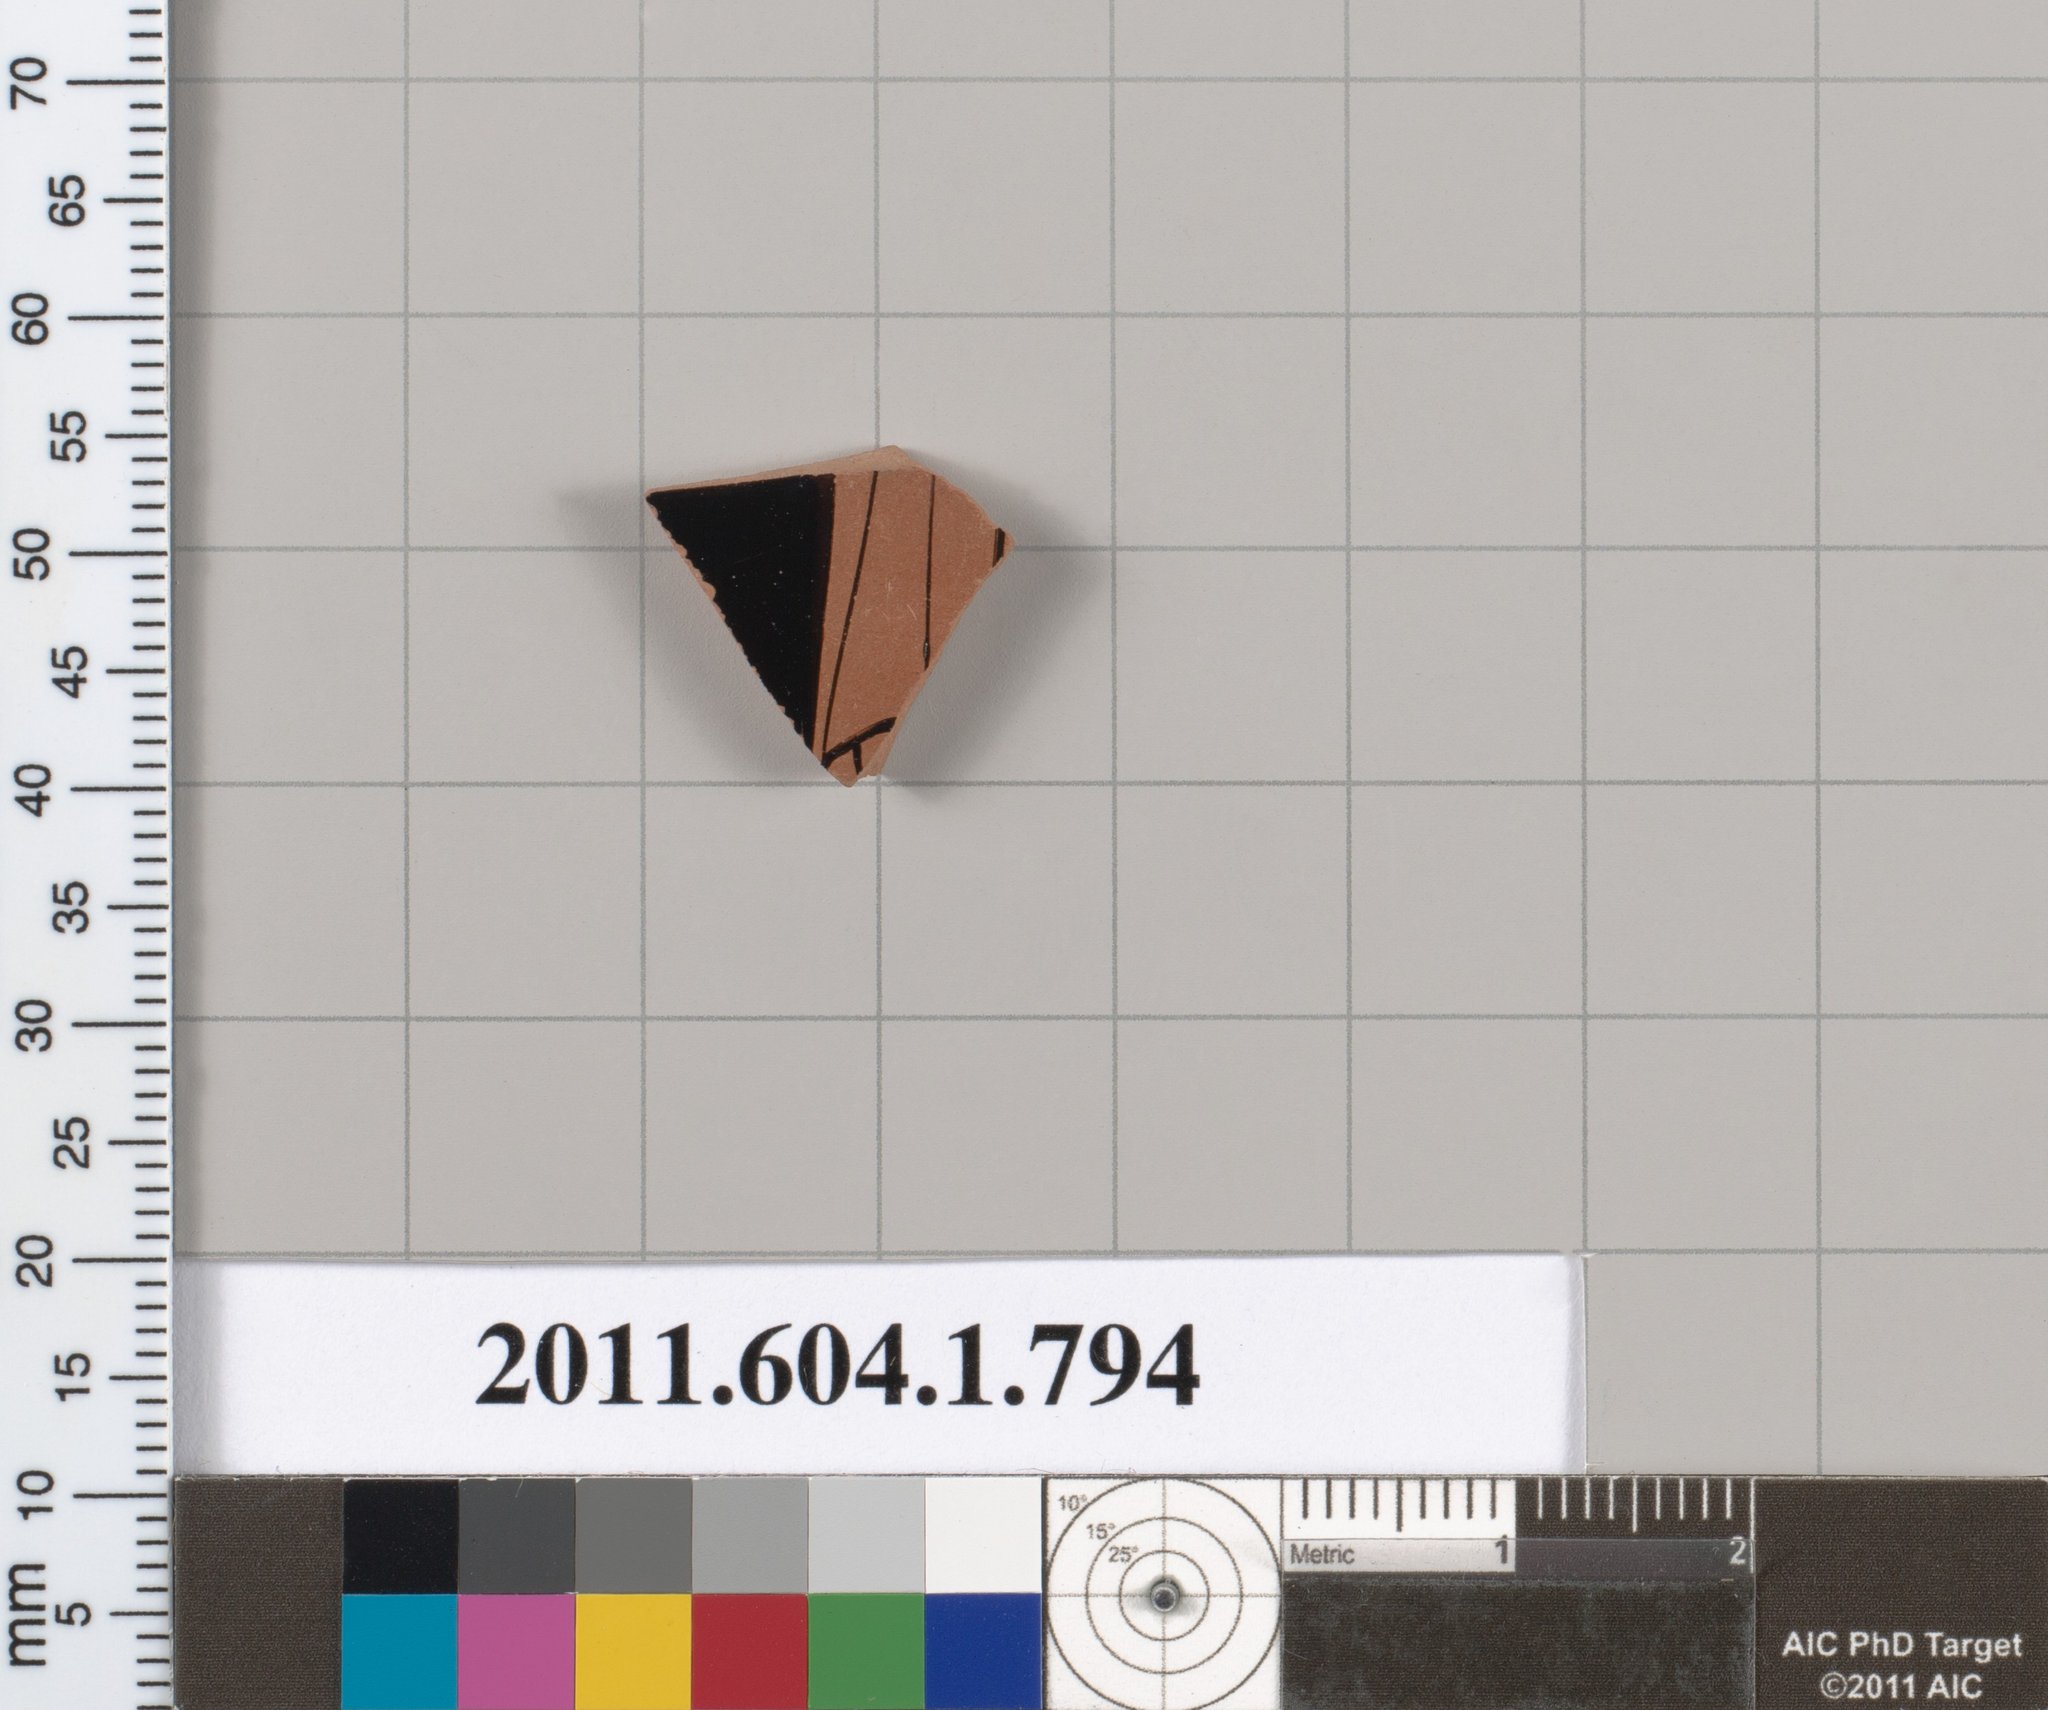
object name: kylix fragment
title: Terracotta fragment of a kylix (drinking cup)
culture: greek, attic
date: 475-451 BCE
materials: terracotta